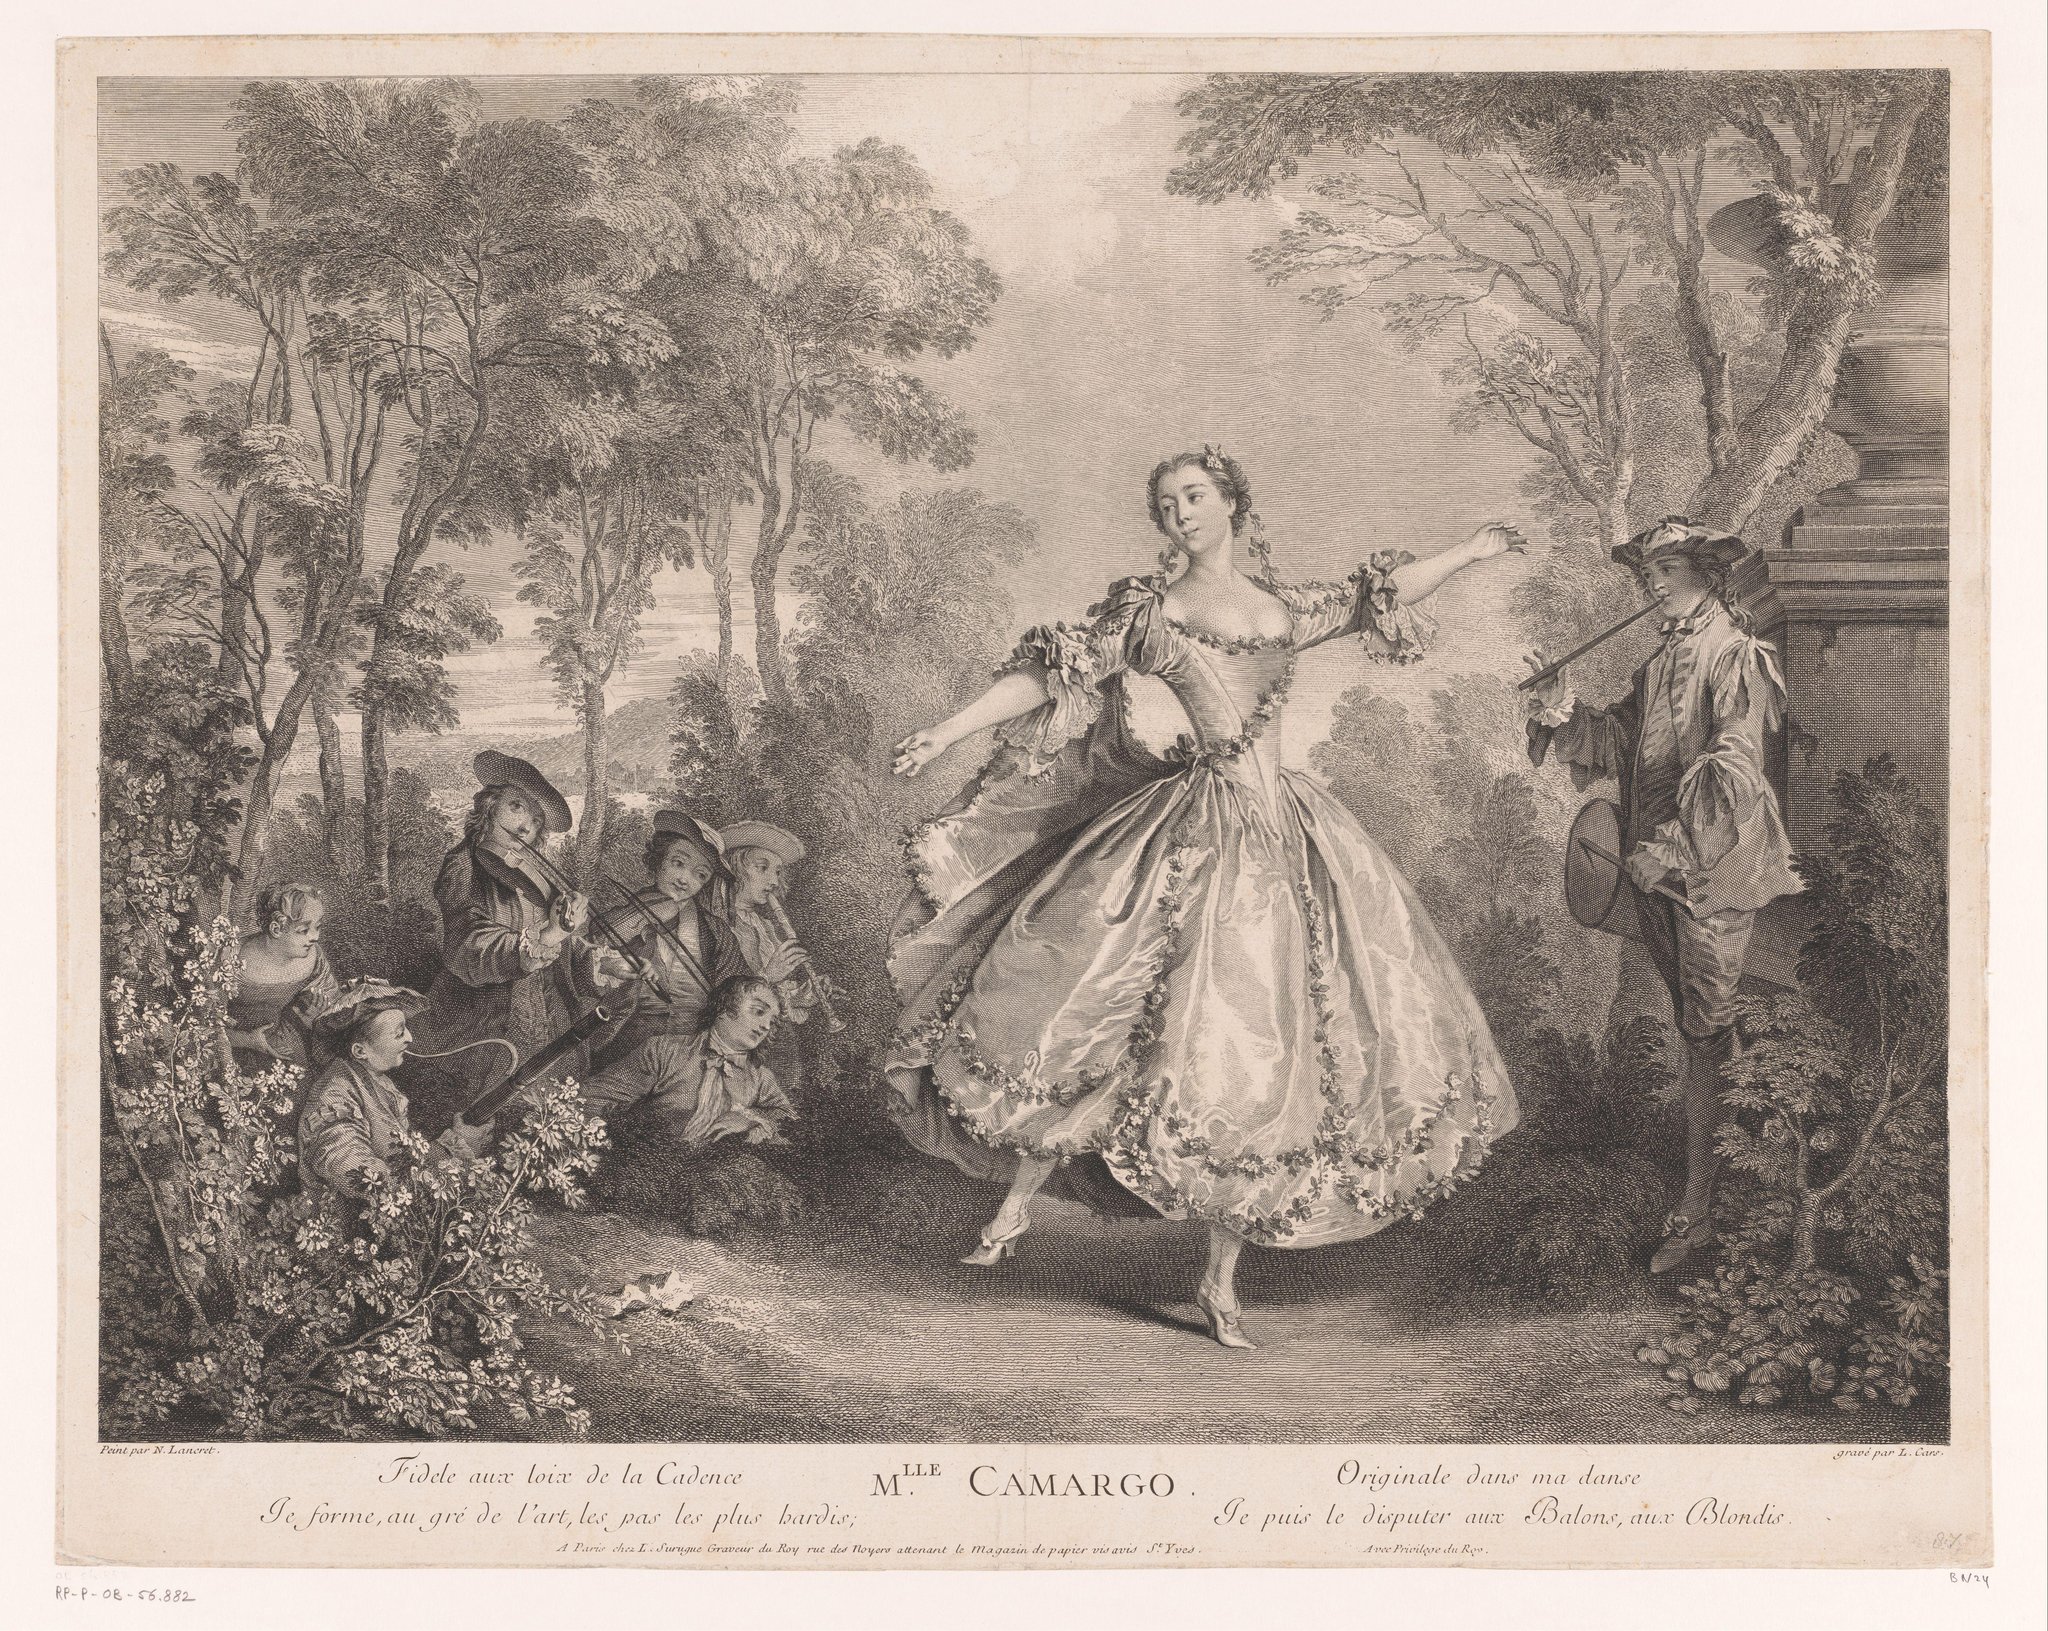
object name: print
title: Mlle. Camargo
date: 1731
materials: paper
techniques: engraving, etching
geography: france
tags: brussels, paris, musician - cc - out of doors, historical persons, female dancer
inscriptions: collector's mark: Lugt 240